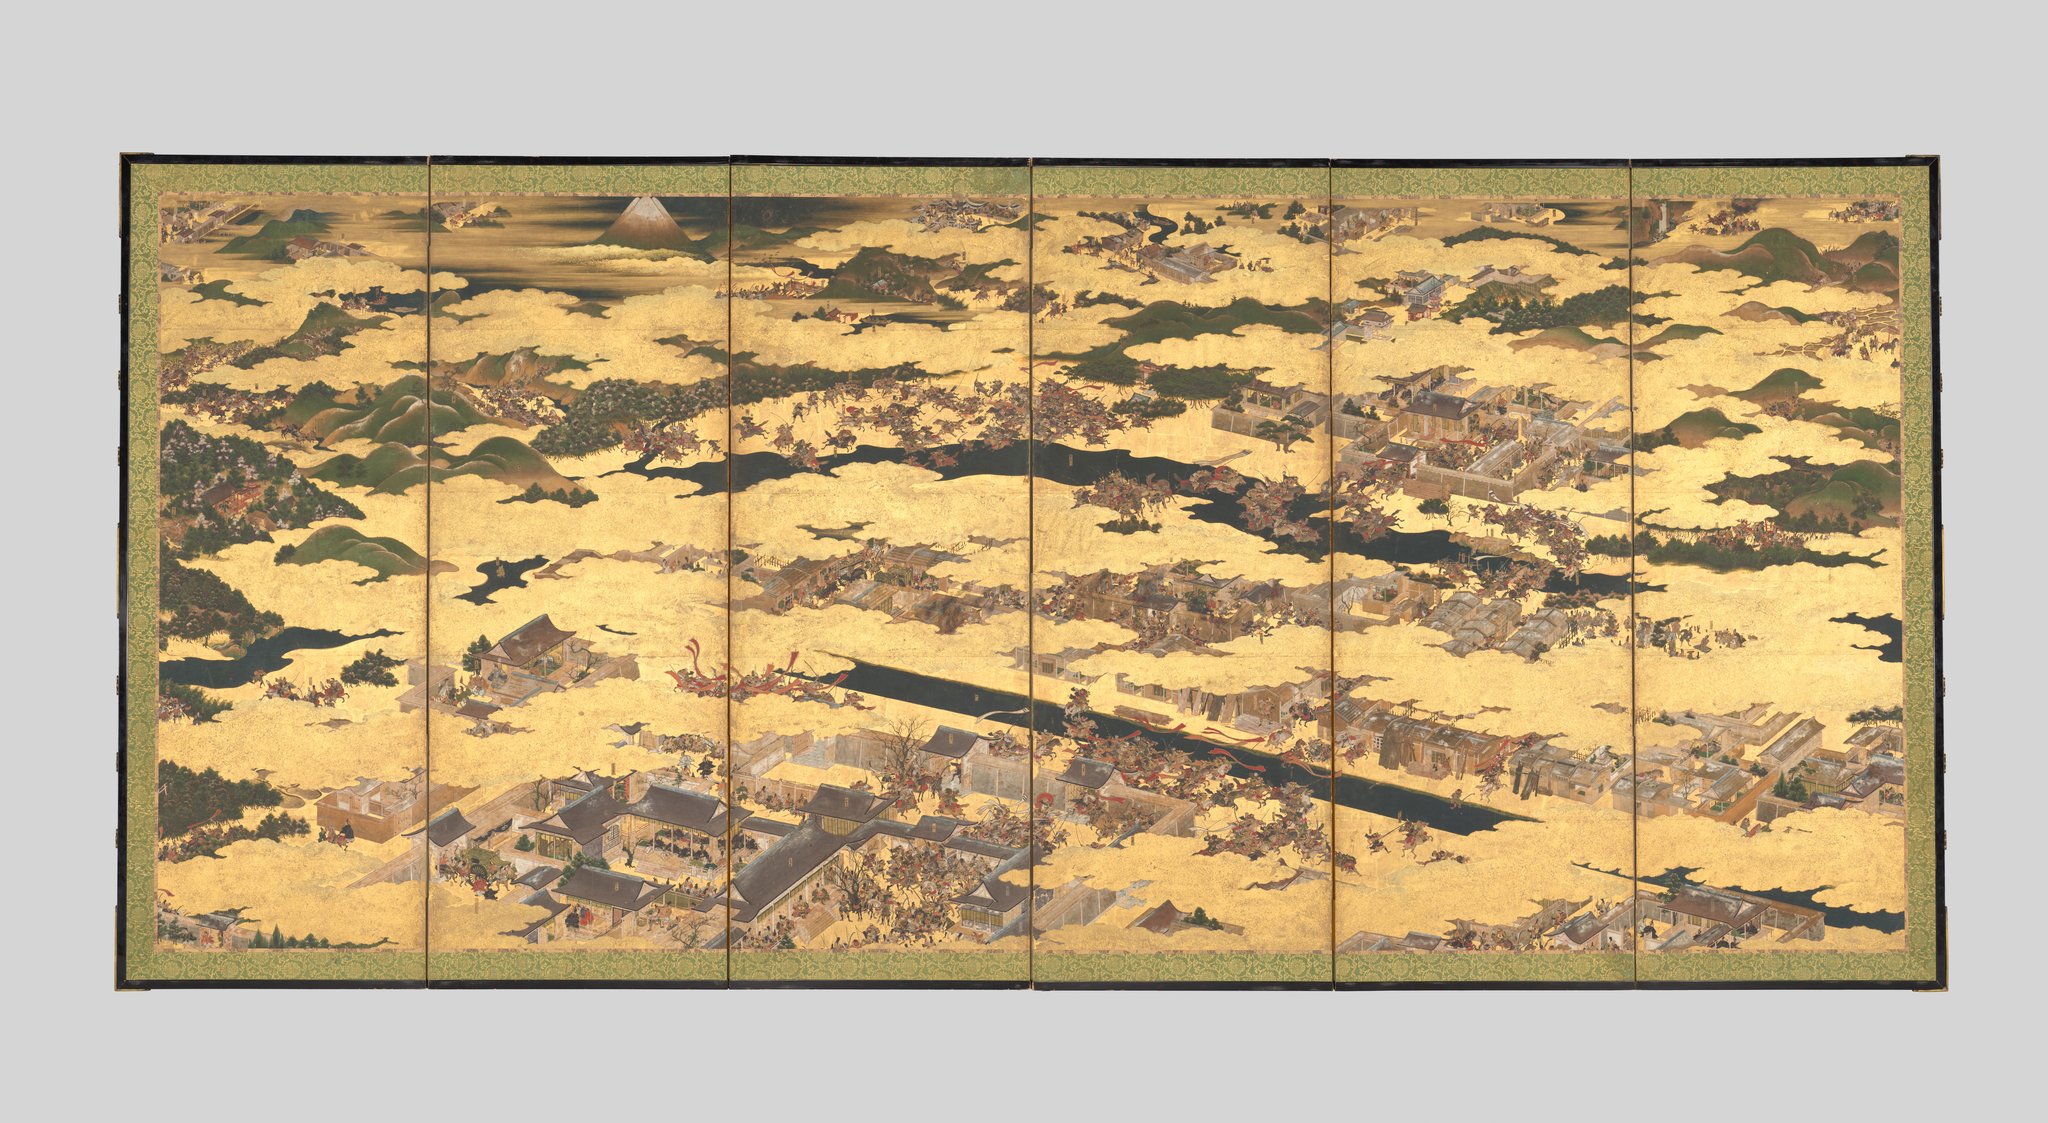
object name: screen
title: The Rebellions of the Hōgen and Heiji Eras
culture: japanese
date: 1601-1700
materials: gold, gold leaf, ink, panel, paper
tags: buildings,battles,men,horses